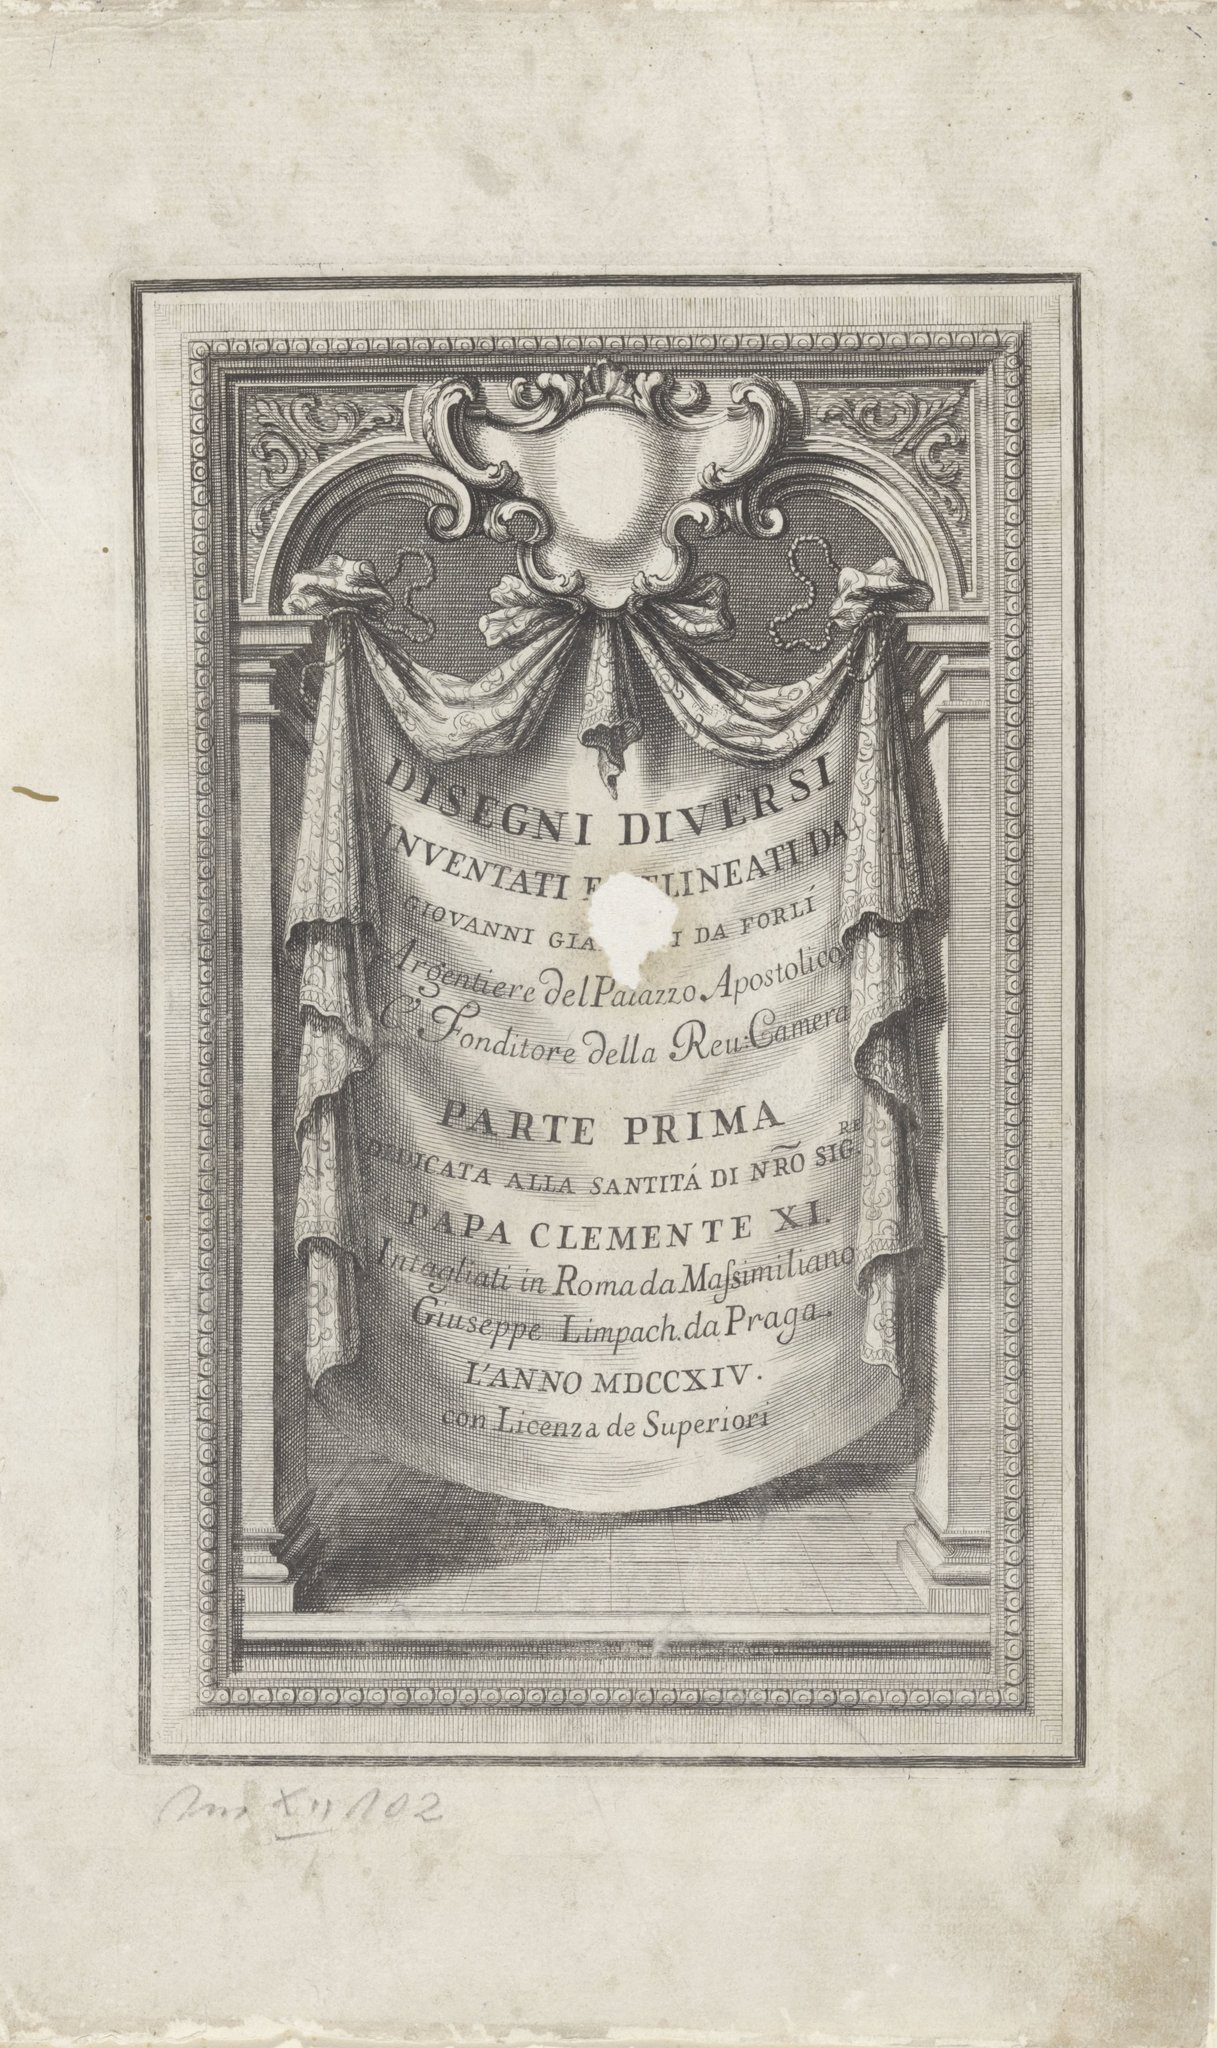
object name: titelprent, frontispice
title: Titelprent met lijst, cartouche en draperie met titel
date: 1714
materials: paper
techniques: etching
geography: italy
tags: ornament ~ cartouche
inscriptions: collector's mark: Lugt 2228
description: Titelprent bij een reeks ornamentprenten.